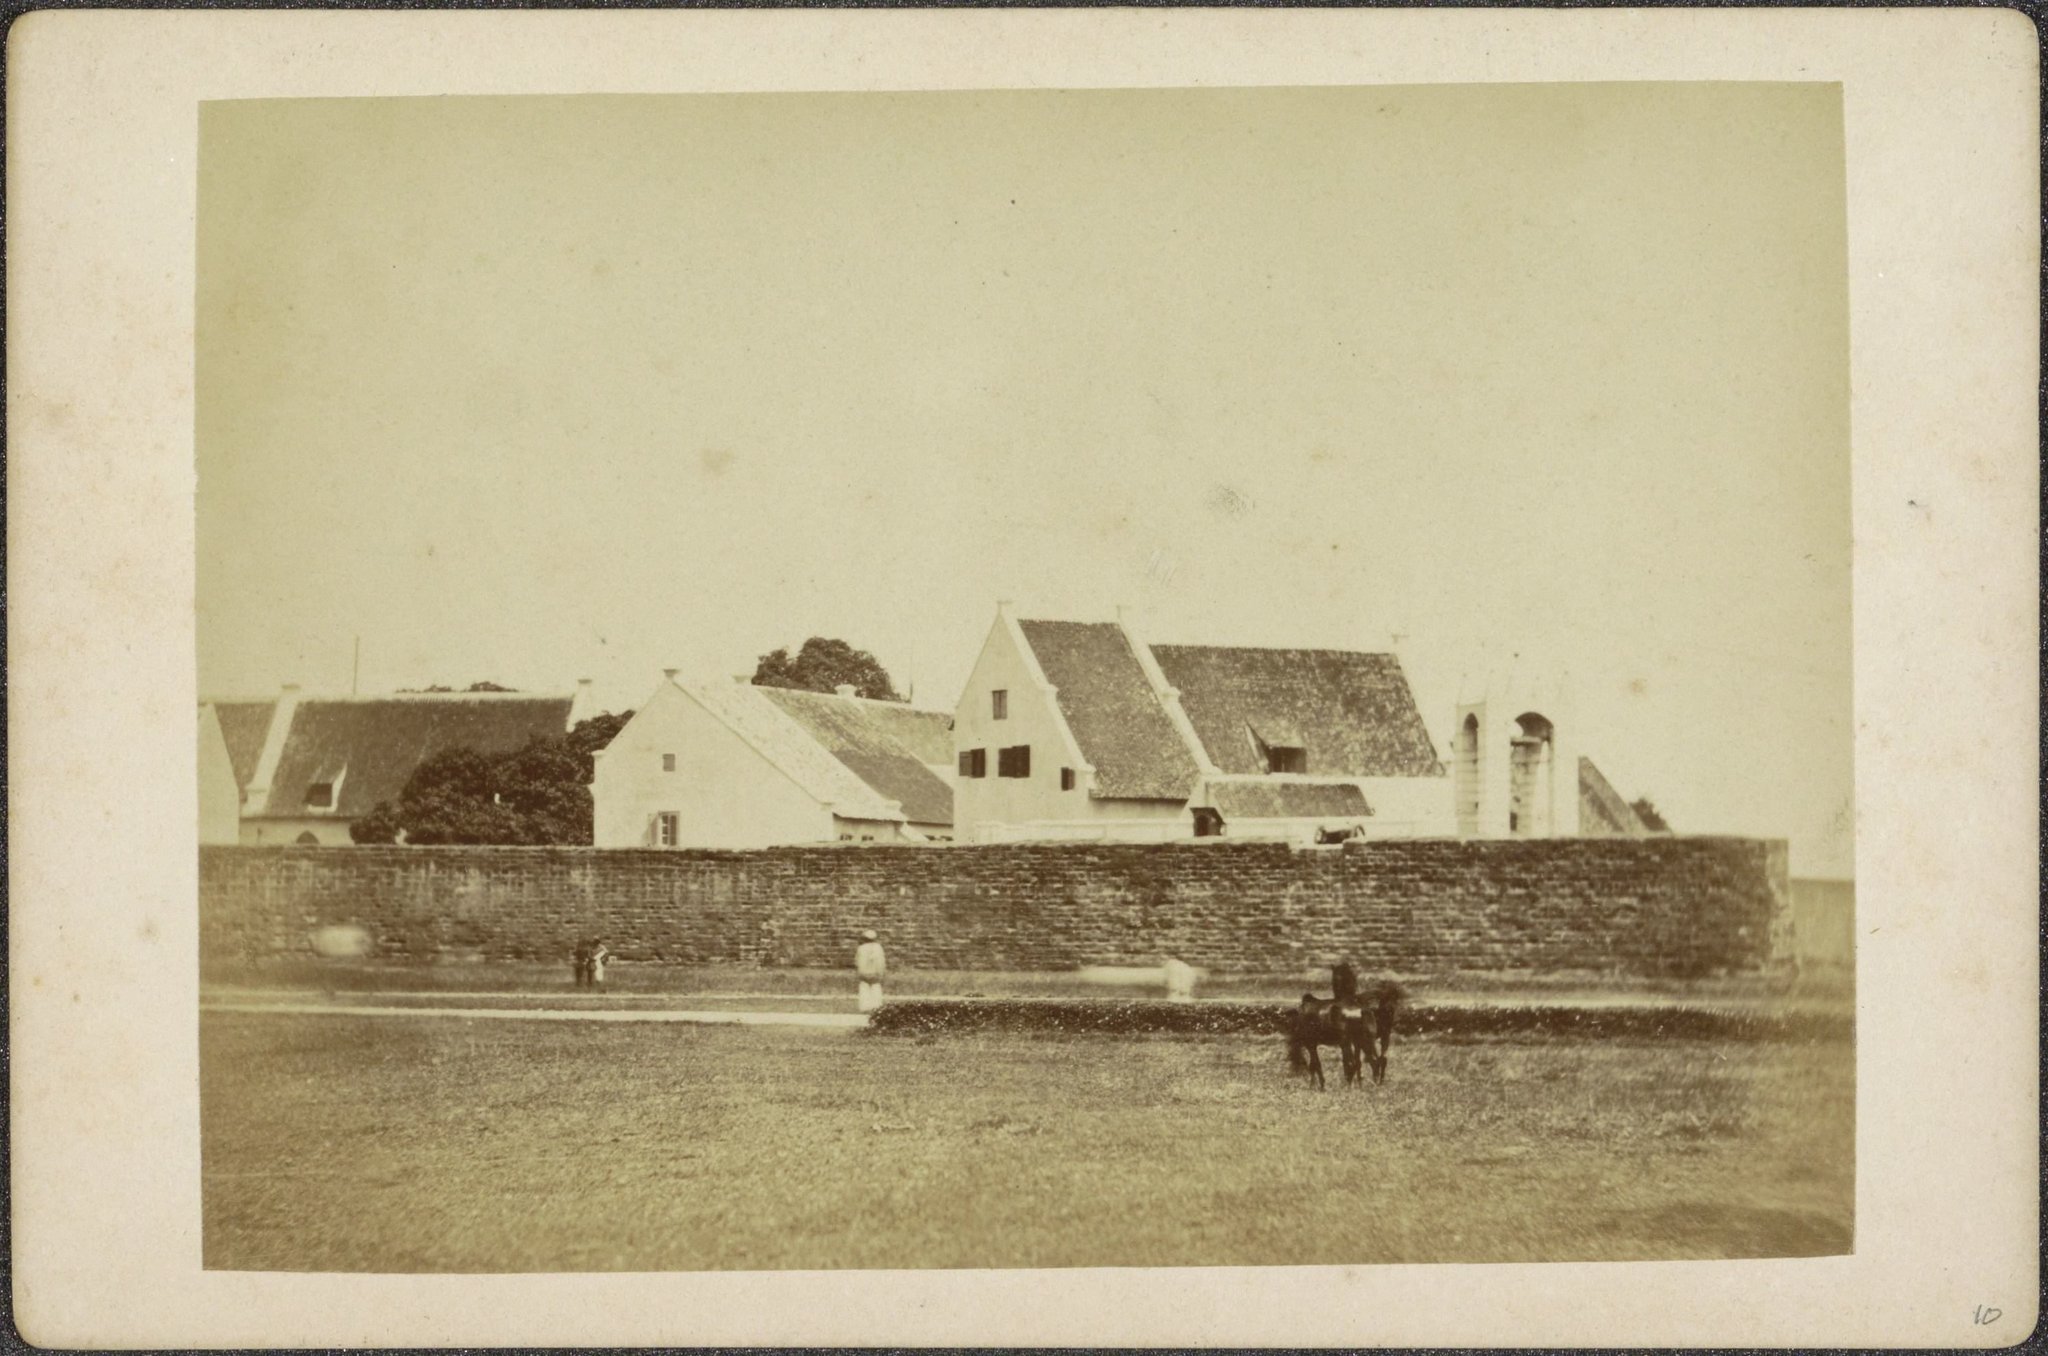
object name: photograph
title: Fort Prins Hendrik op de Molukken, van buiten de muren gezien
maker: Anonymous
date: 1860-1900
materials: cardboard, paper, photographic support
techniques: albumen print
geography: moluccas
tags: fortress, dutch east indies, the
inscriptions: inscription: ‘Molukken. Fort Prins Hendrik te Hacassar’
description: Onderdeel van Album met foto's van de Molukken.